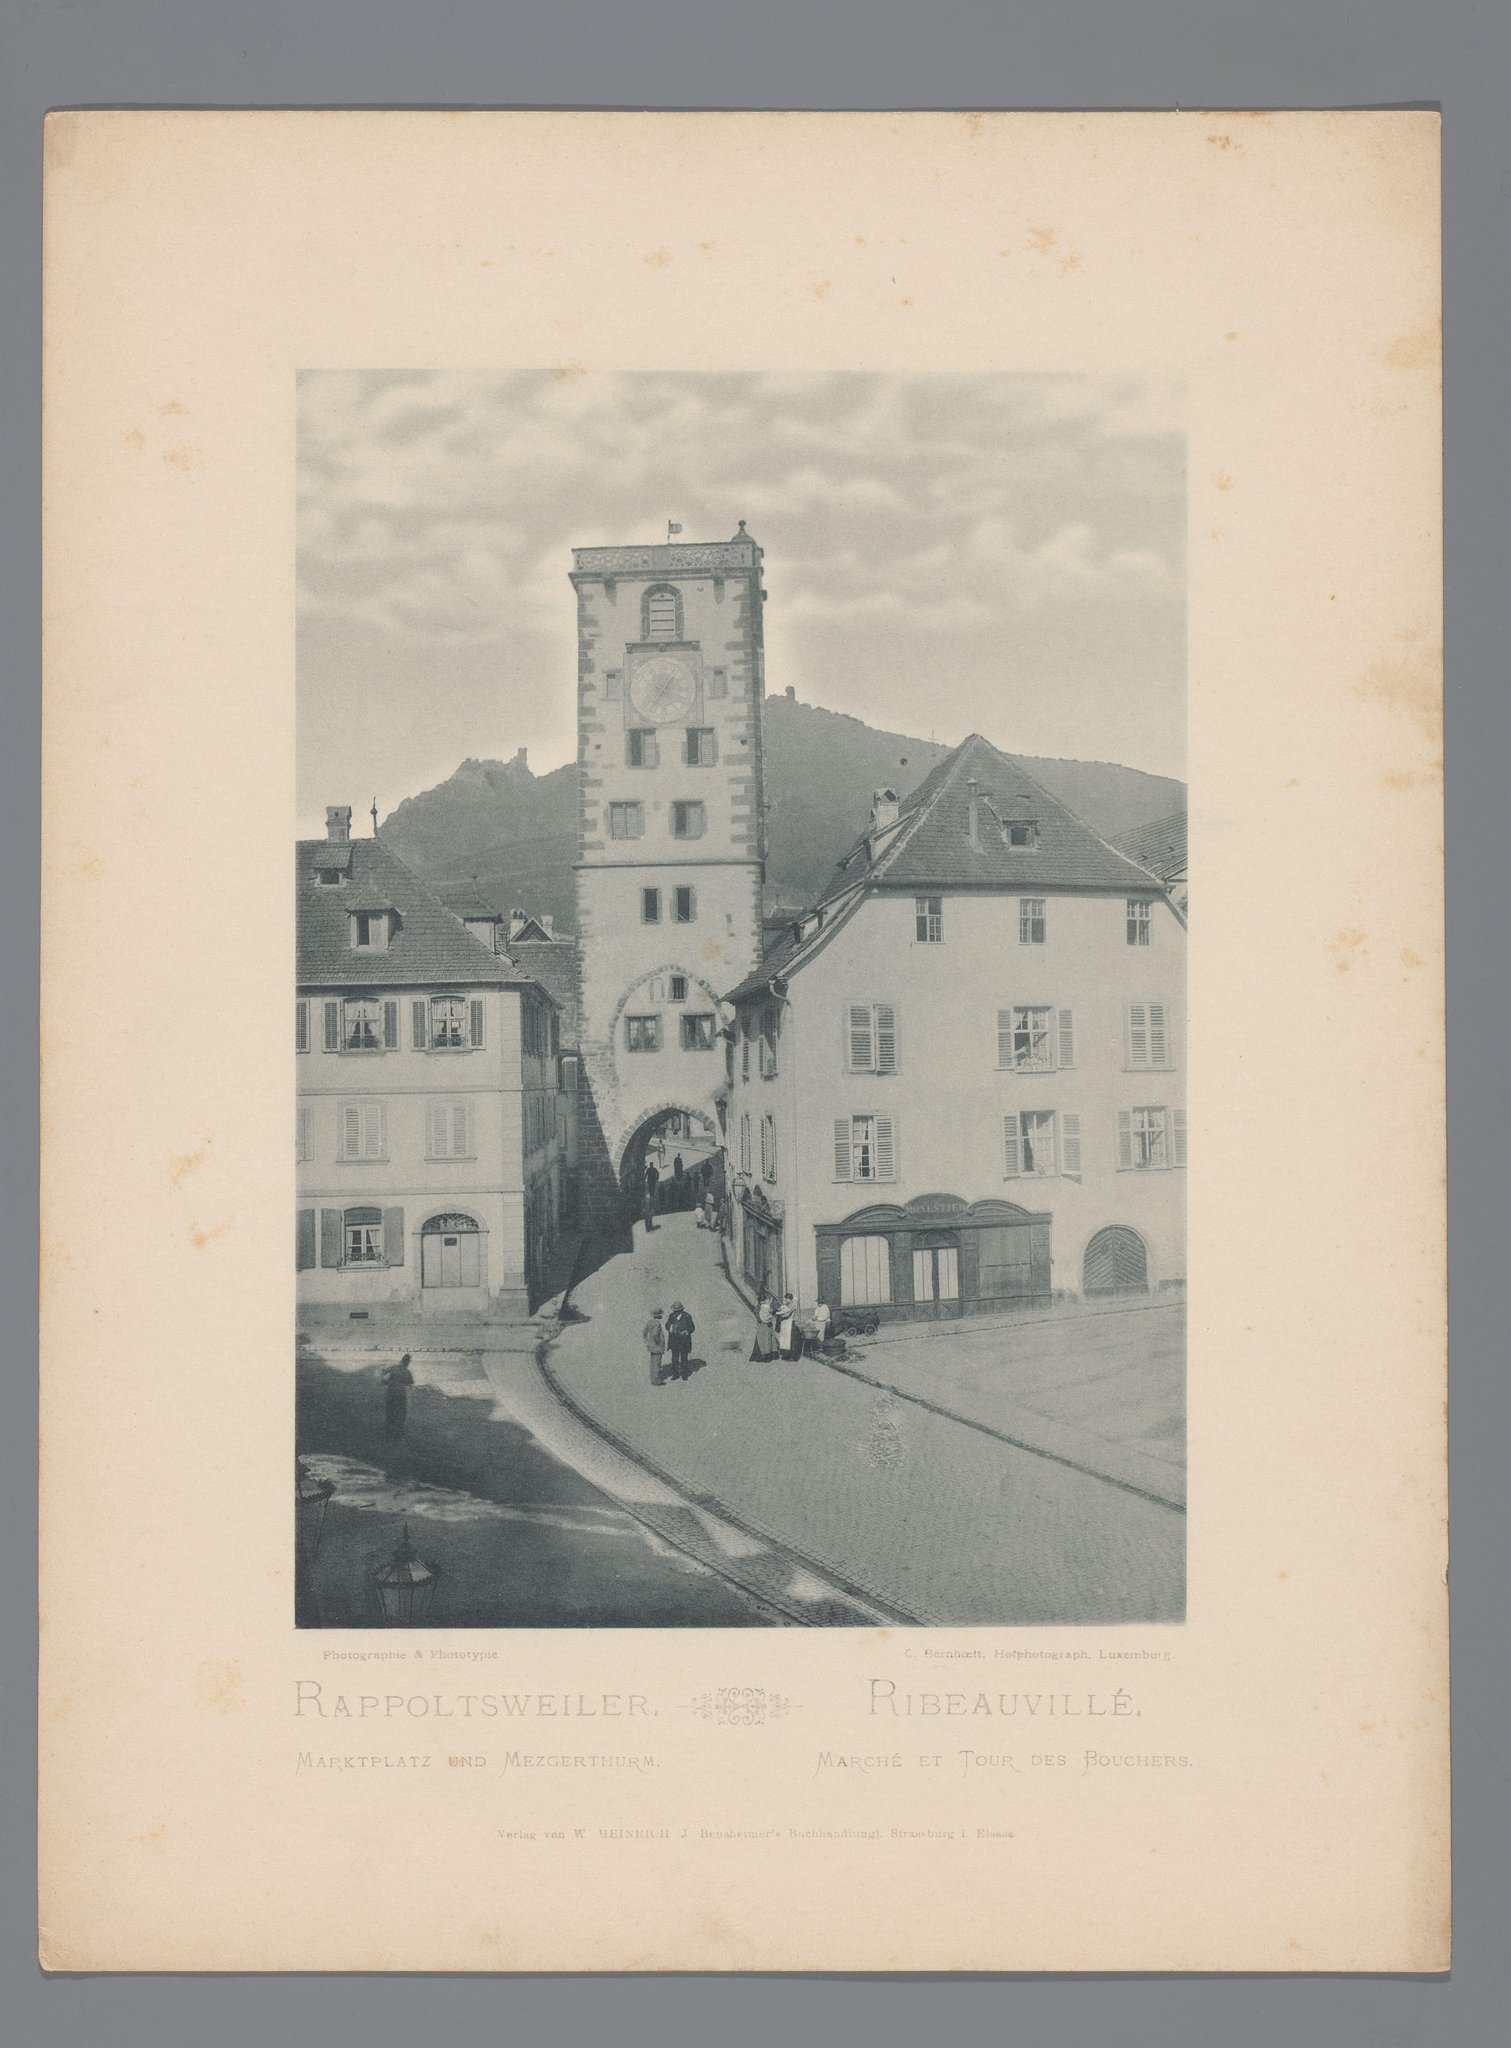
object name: photomechanical print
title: Gezicht op de Tour des Bouchers te Ribeauvillé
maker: charles bernhoeft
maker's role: publisher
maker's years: 1859-1933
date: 1889-1894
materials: paper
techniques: photograph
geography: luxembourg city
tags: tower, clock tower ~ monumental adornment (+ city(-scape) with figures, staffage)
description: Deze prent maakt deel uit van een omslag met 100 prenten.